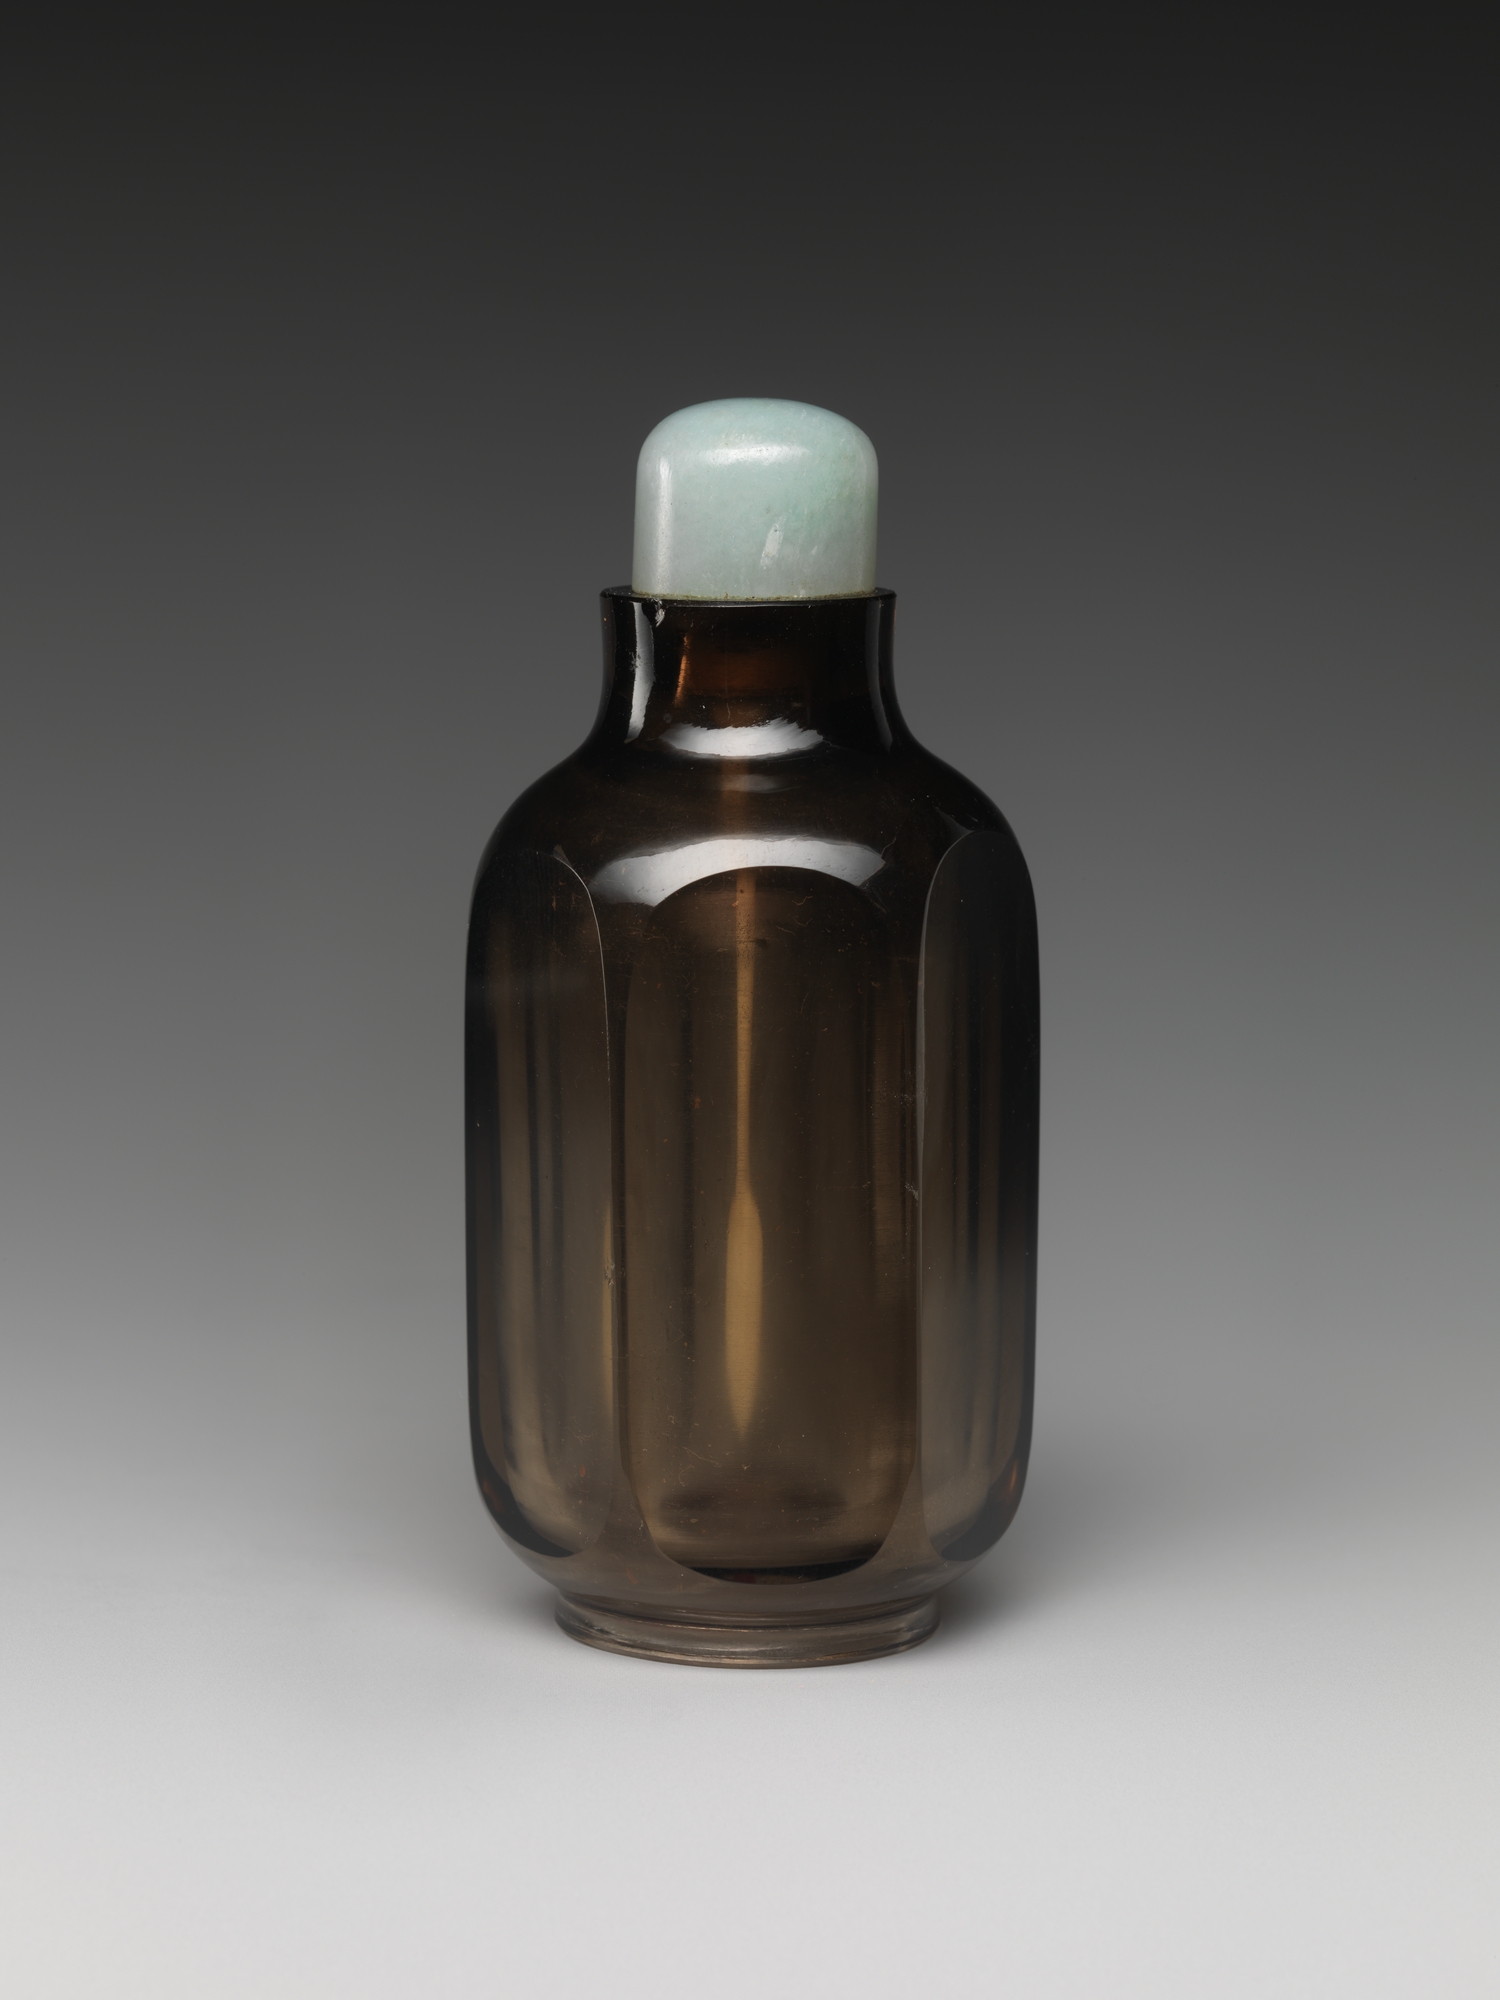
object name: snuff bottle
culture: chinese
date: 1767-1833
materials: jade, quartz